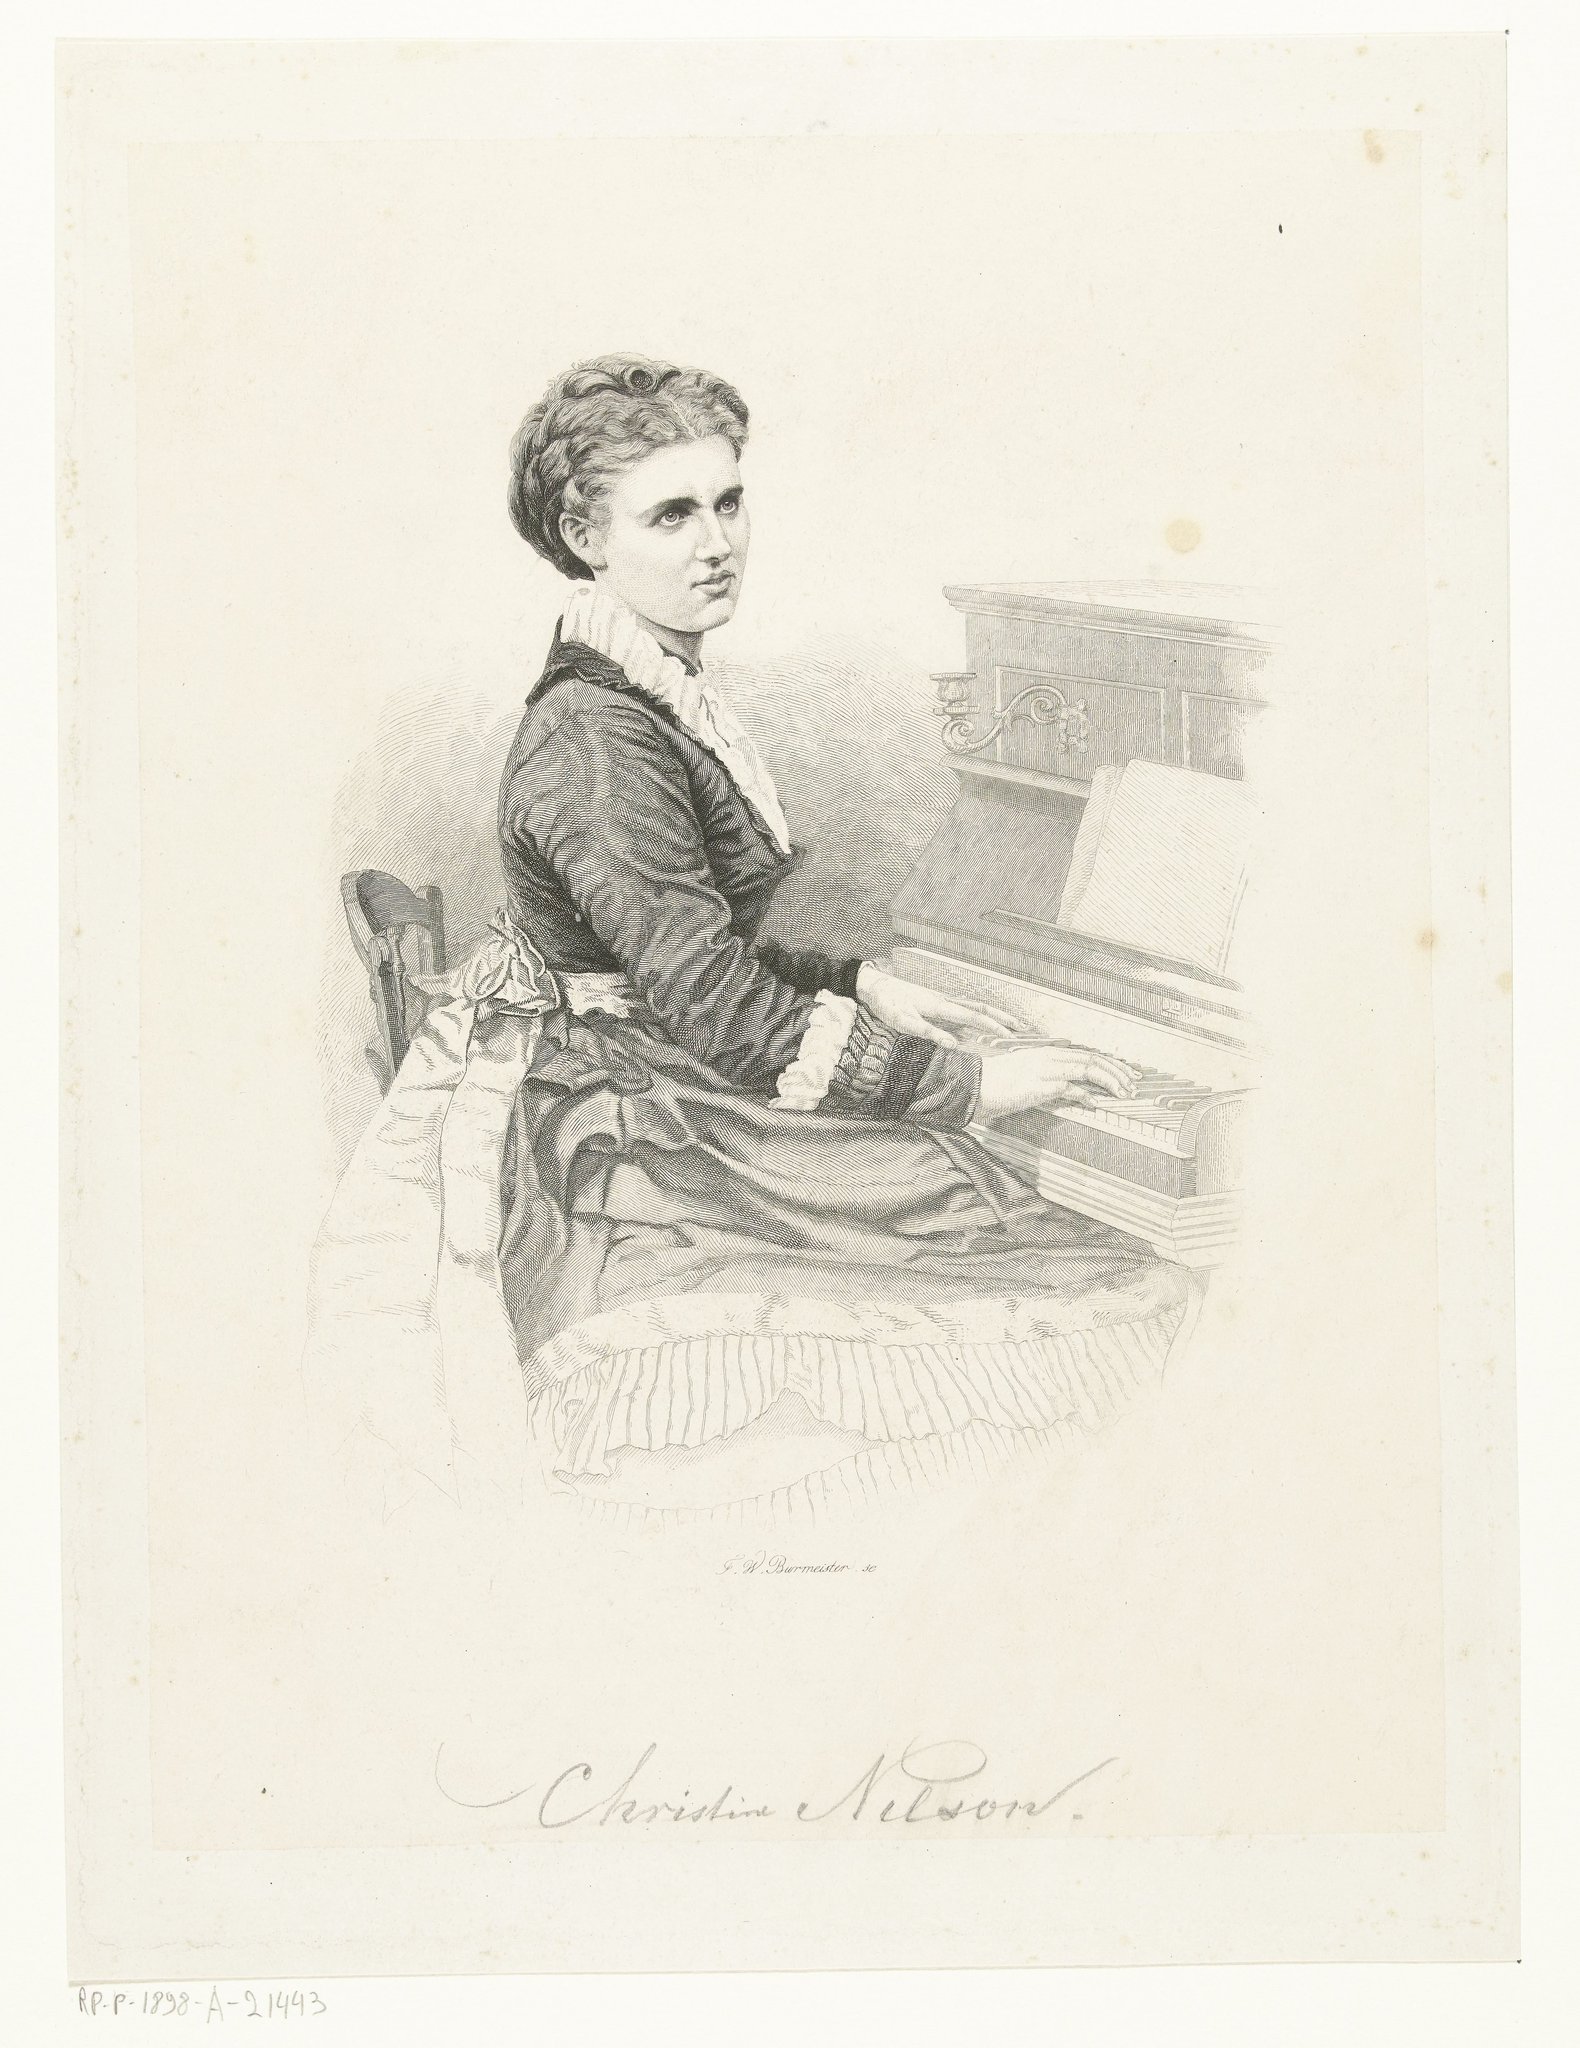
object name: print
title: Portret van Christine Nilson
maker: friedrich wilhelm burmeister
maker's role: print maker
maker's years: 1845-1933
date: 1855-1898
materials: paper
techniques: engraving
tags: zangeres, christina nilsson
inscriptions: collector's mark: Lugt 964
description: Portret van Christine Nilson, een Zweedse operazangeres. Ze zit piano te spelen, naar rechts gewend.